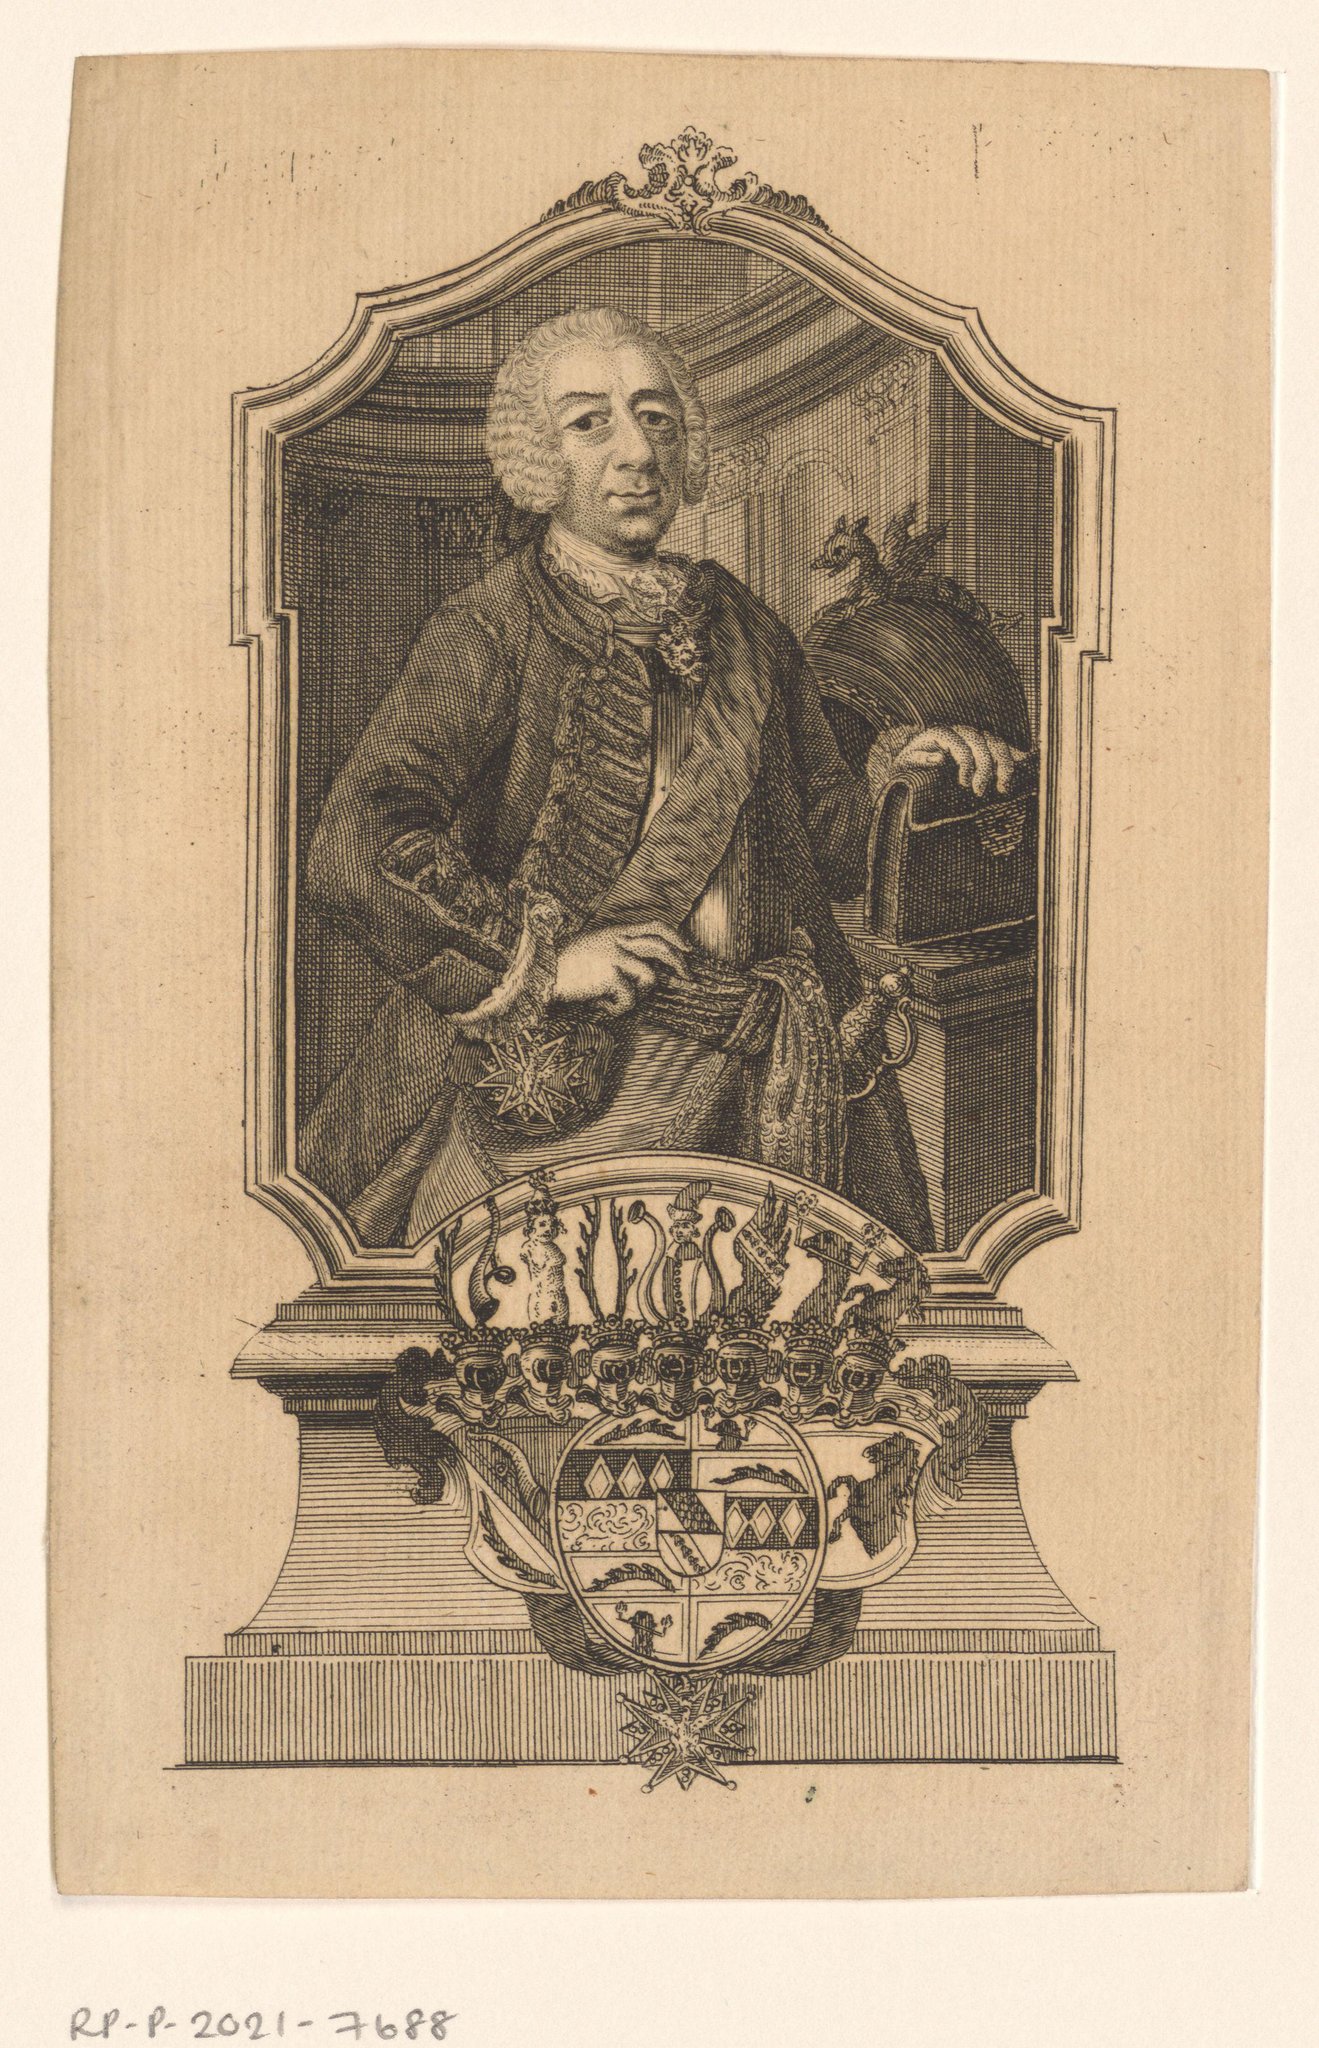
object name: print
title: Portret van een onbekende man, aangeduid als Tattenbach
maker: Anonymous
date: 1750-1799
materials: paper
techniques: engraving, etching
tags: armorial bearing, heraldry, historical persons not known by name